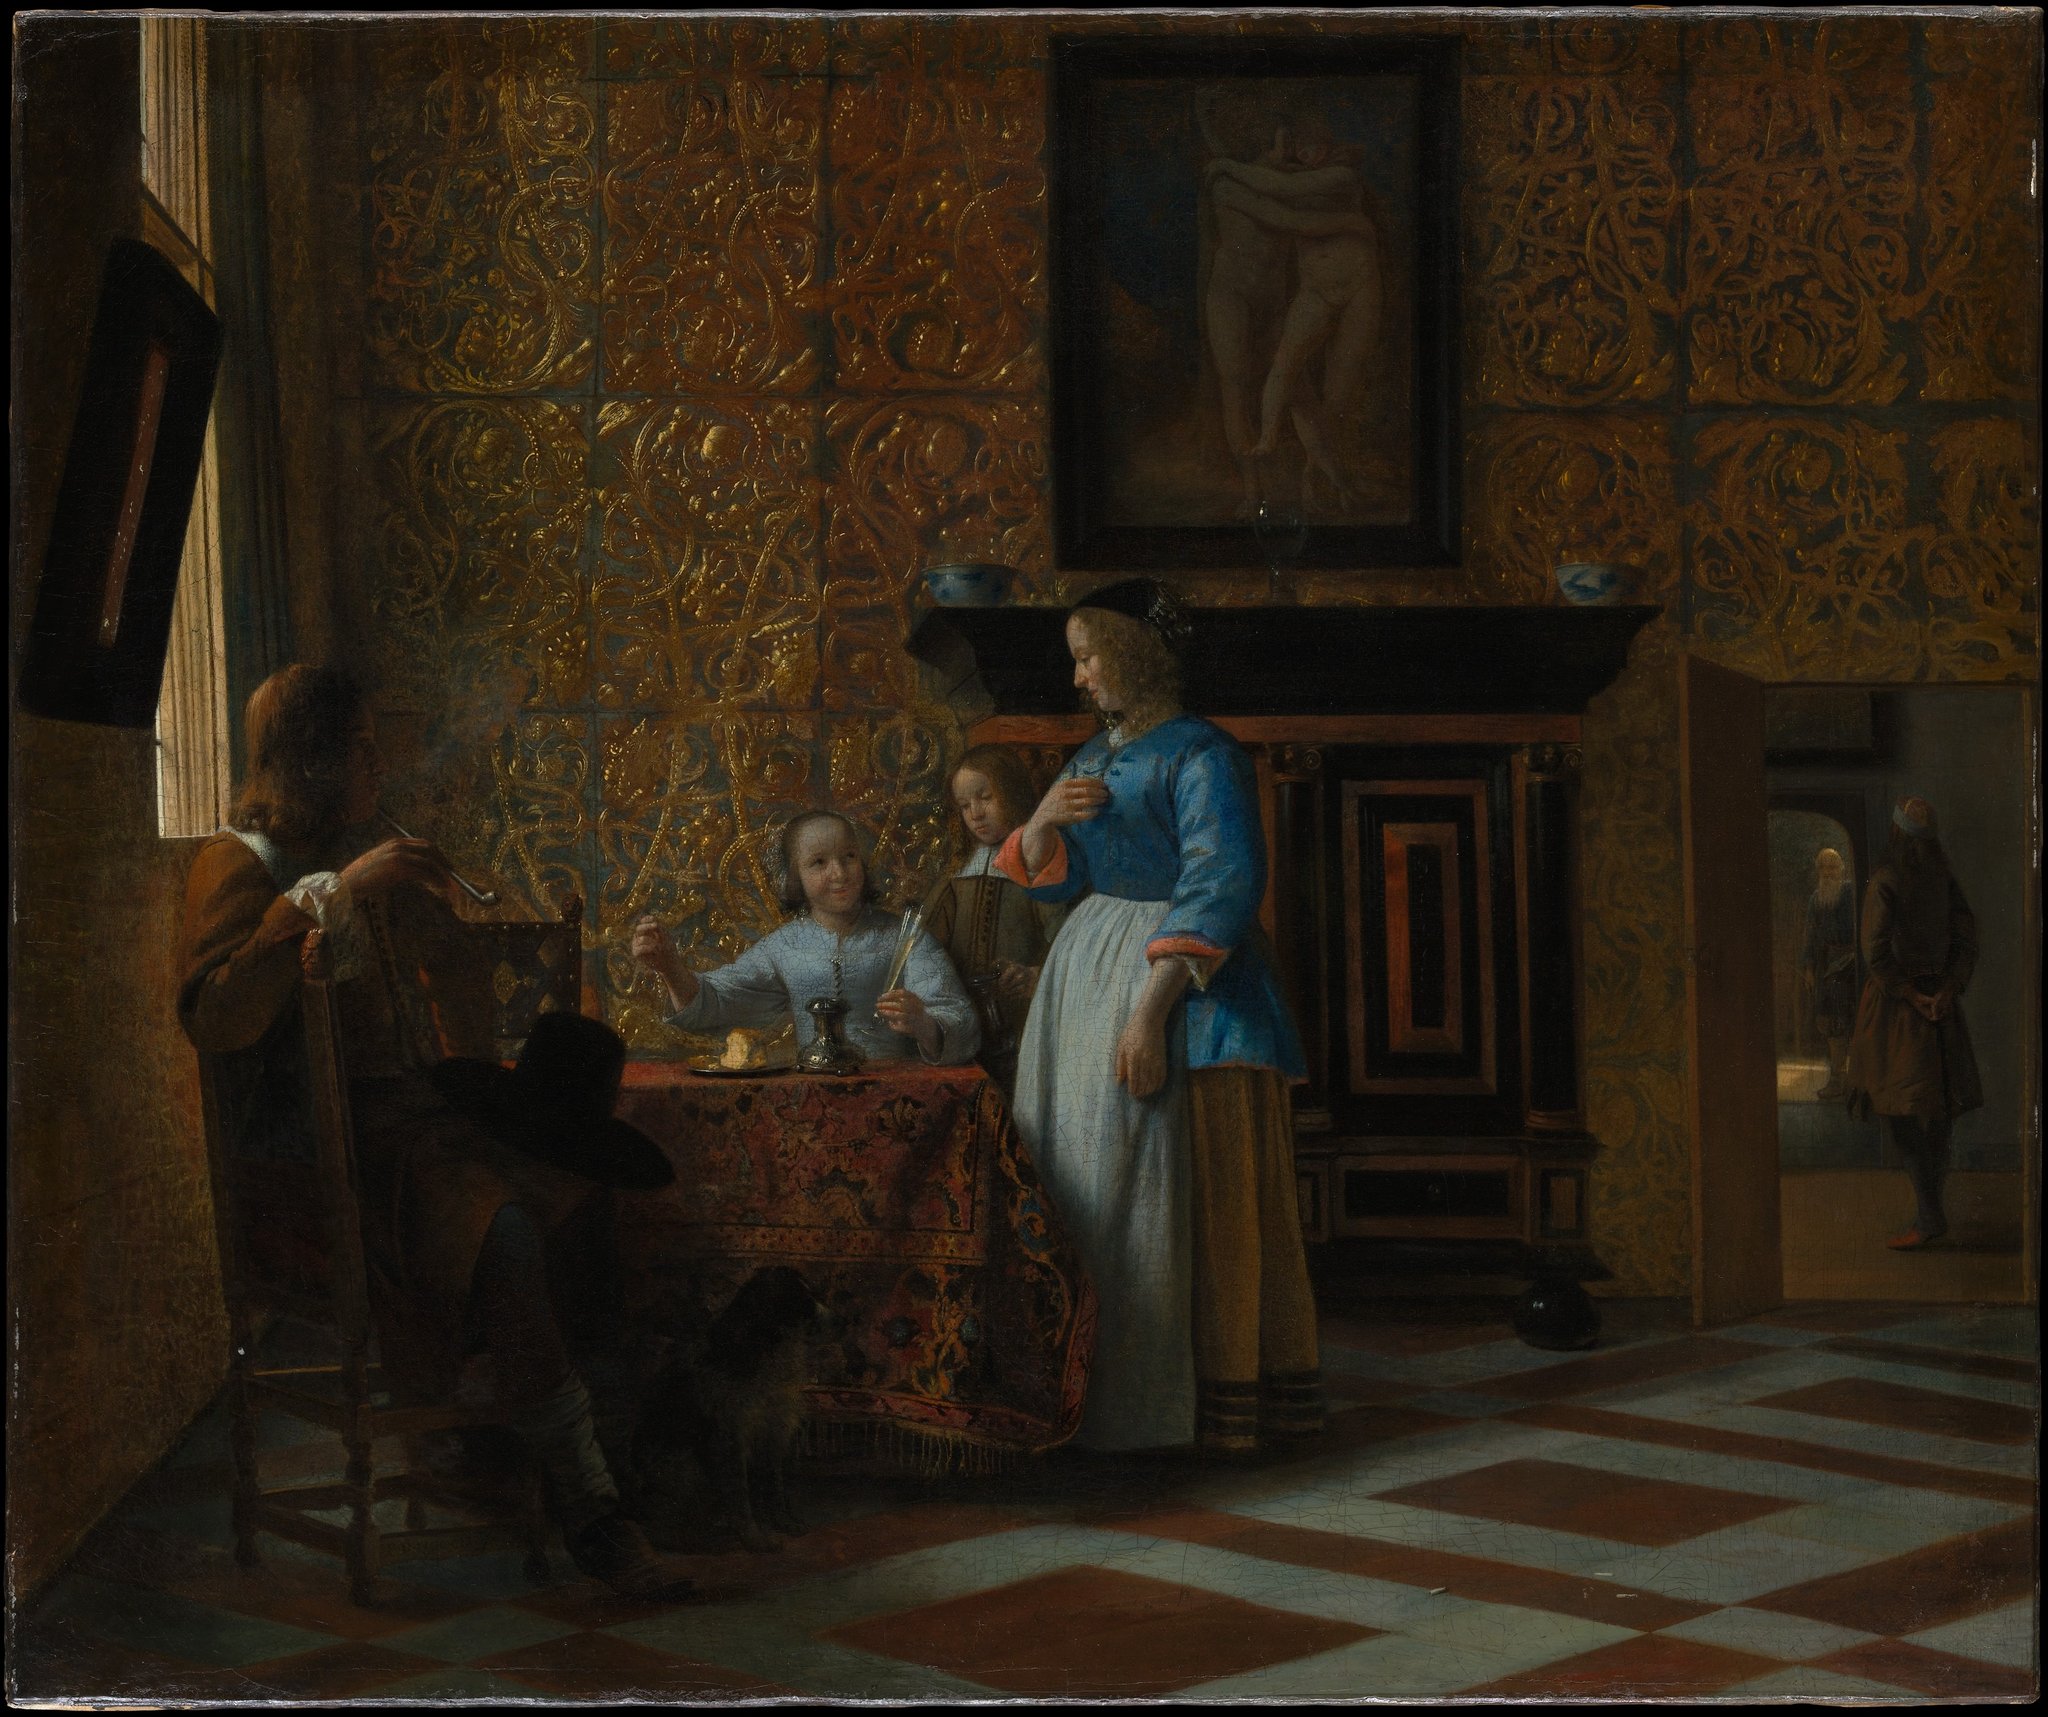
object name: painting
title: Leisure Time in an Elegant Setting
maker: pieter de hooch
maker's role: artist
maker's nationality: dutch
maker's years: 1629-1684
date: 1663-1665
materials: canvas, oil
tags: interiors,girls,men,women,smoking,dogs